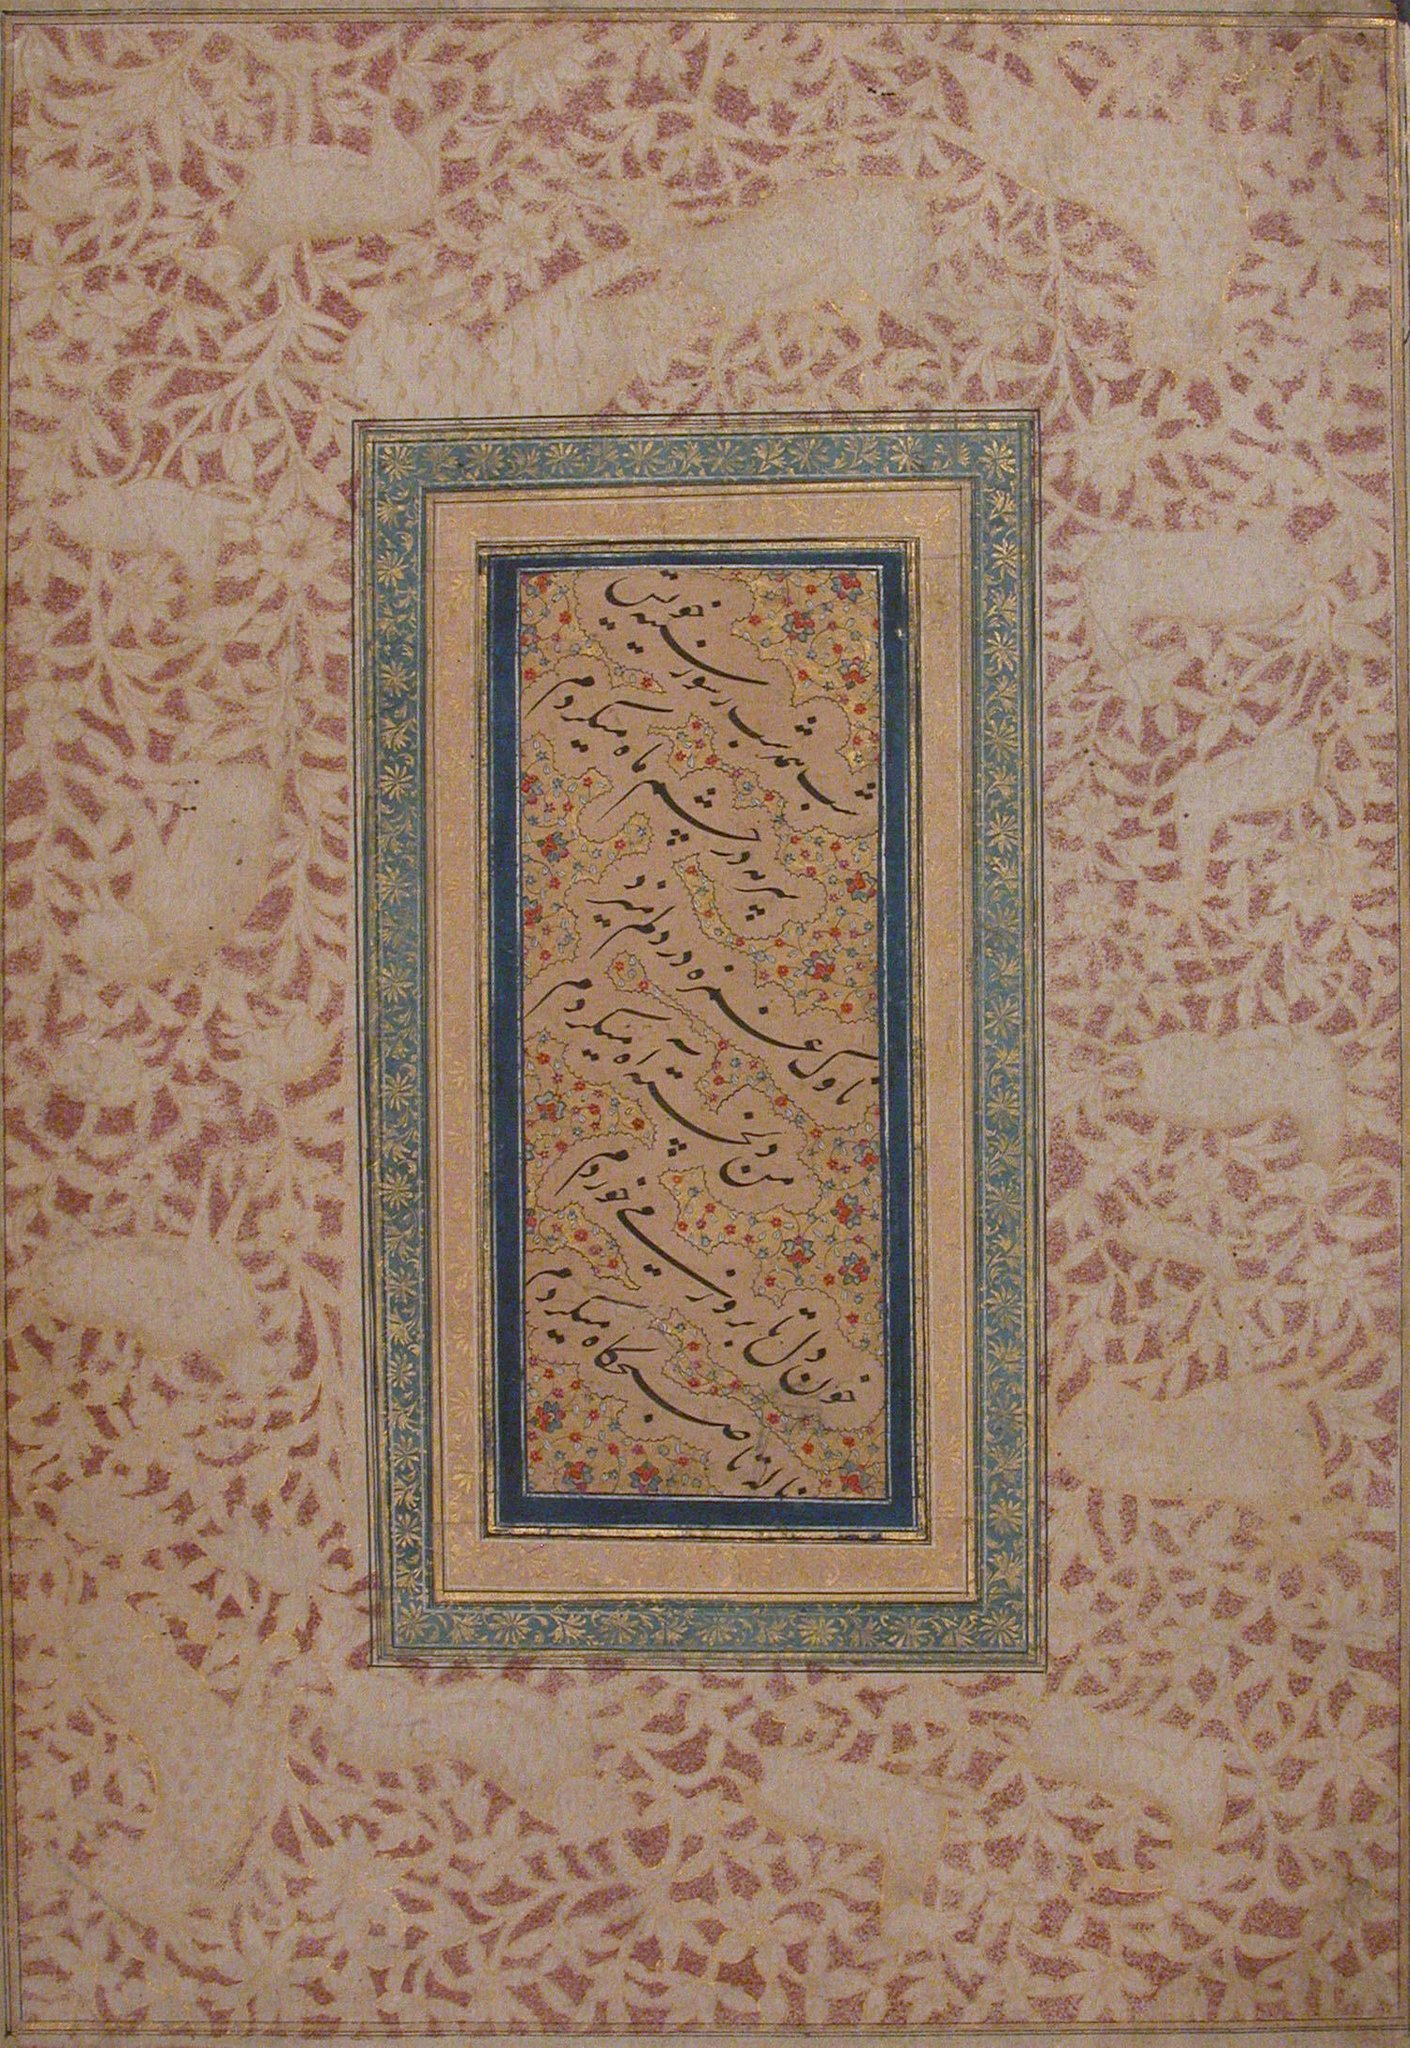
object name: non illustrated album leaf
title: Calligraphic Folio with Persian Verses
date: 1601-1700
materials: gold, paper, watercolor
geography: india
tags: animals,persian,calligraphy